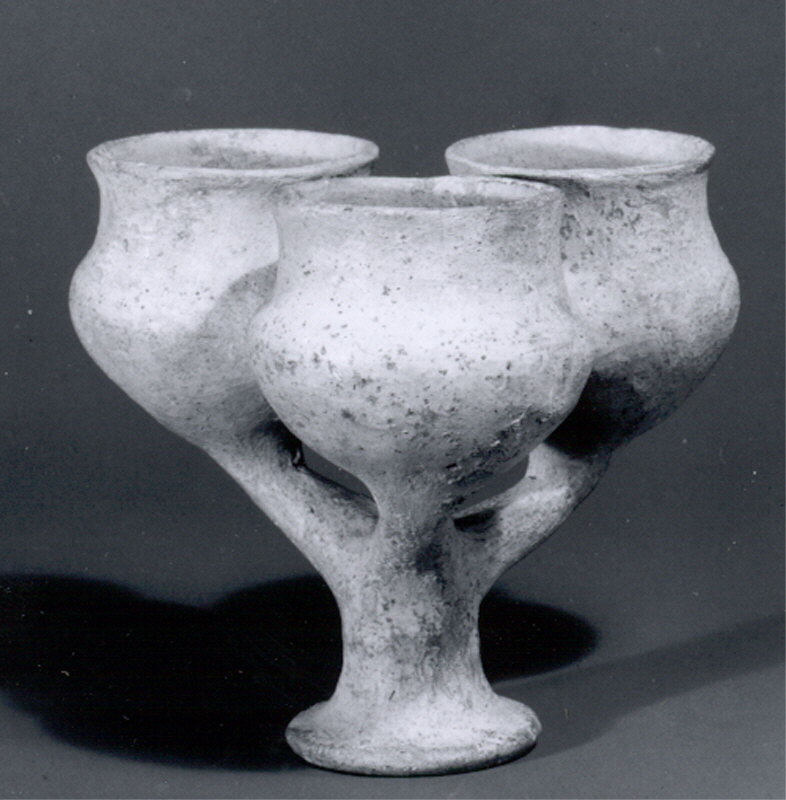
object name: vase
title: Tripartite vase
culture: iranian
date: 1000 BCE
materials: ceramic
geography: northwestern iran